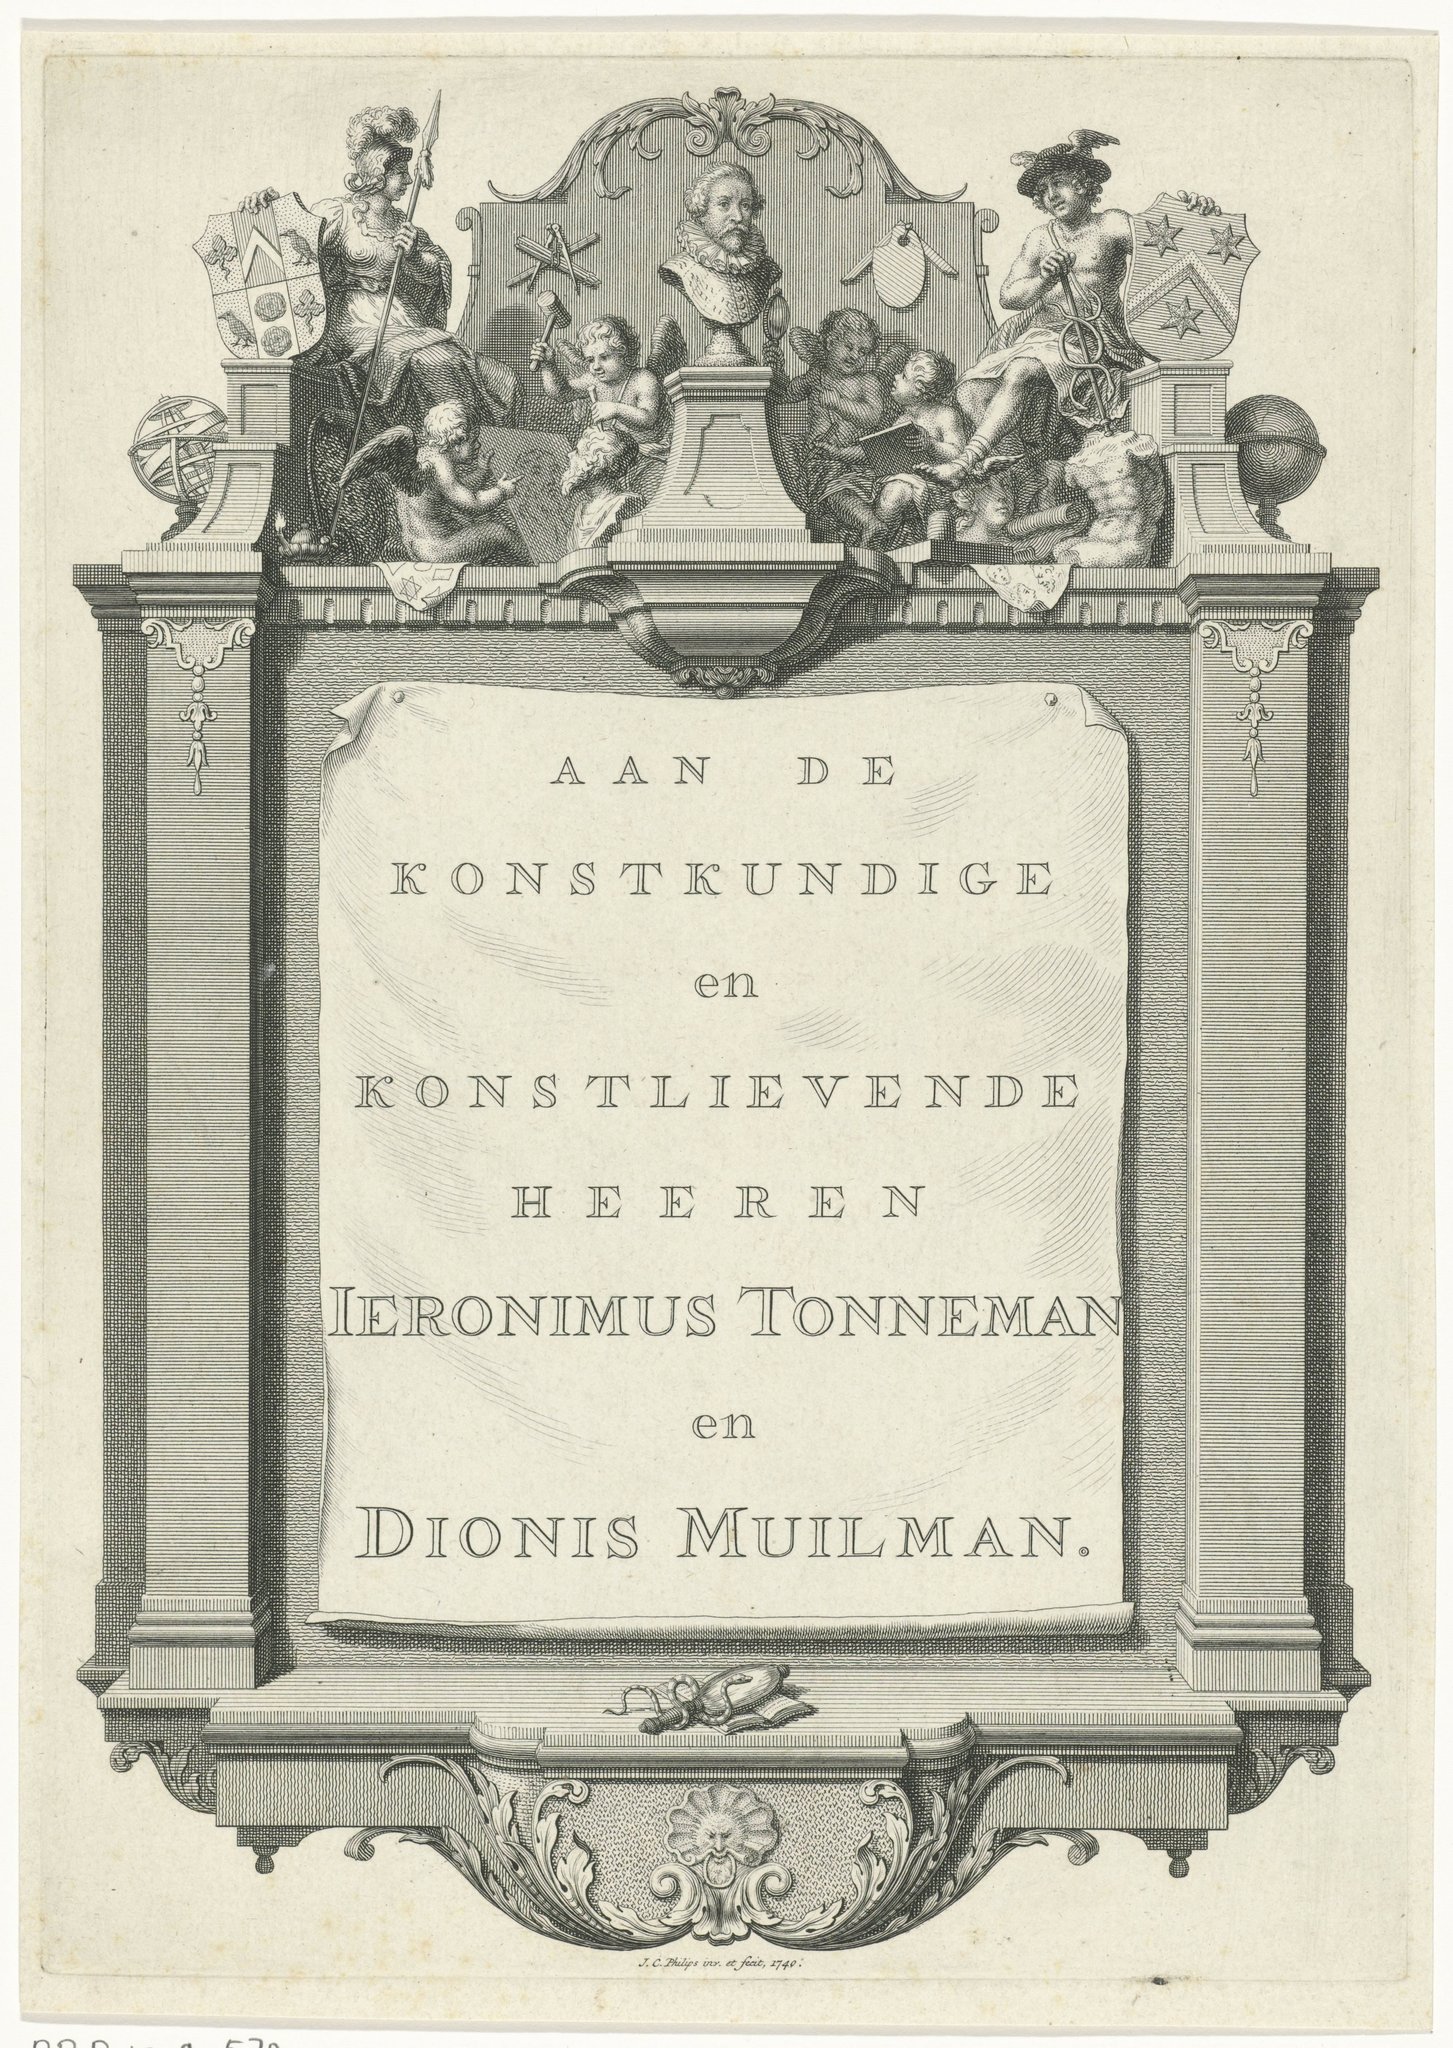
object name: print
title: Vignet met portretbuste en symbolen van de kunsten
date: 1740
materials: paper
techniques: etching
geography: amsterdam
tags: (story of) minerva (pallas, athena), (story of) mercury (hermes), symbolic representations, allegories and emblems ~ art; 'arte' (ripa)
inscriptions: collector's mark: Lugt 2228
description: Ornamentele omlijsting waaraan een vel papier met een opdracht aan twee kunstverzamelaars in het Nederlands. De omlijsting wordt bekroond door een portretbuste, omringd door putti die de kunsten beoefenen en geflankeerd door Minerva en Mercurius, met wapenschilden in de handen.